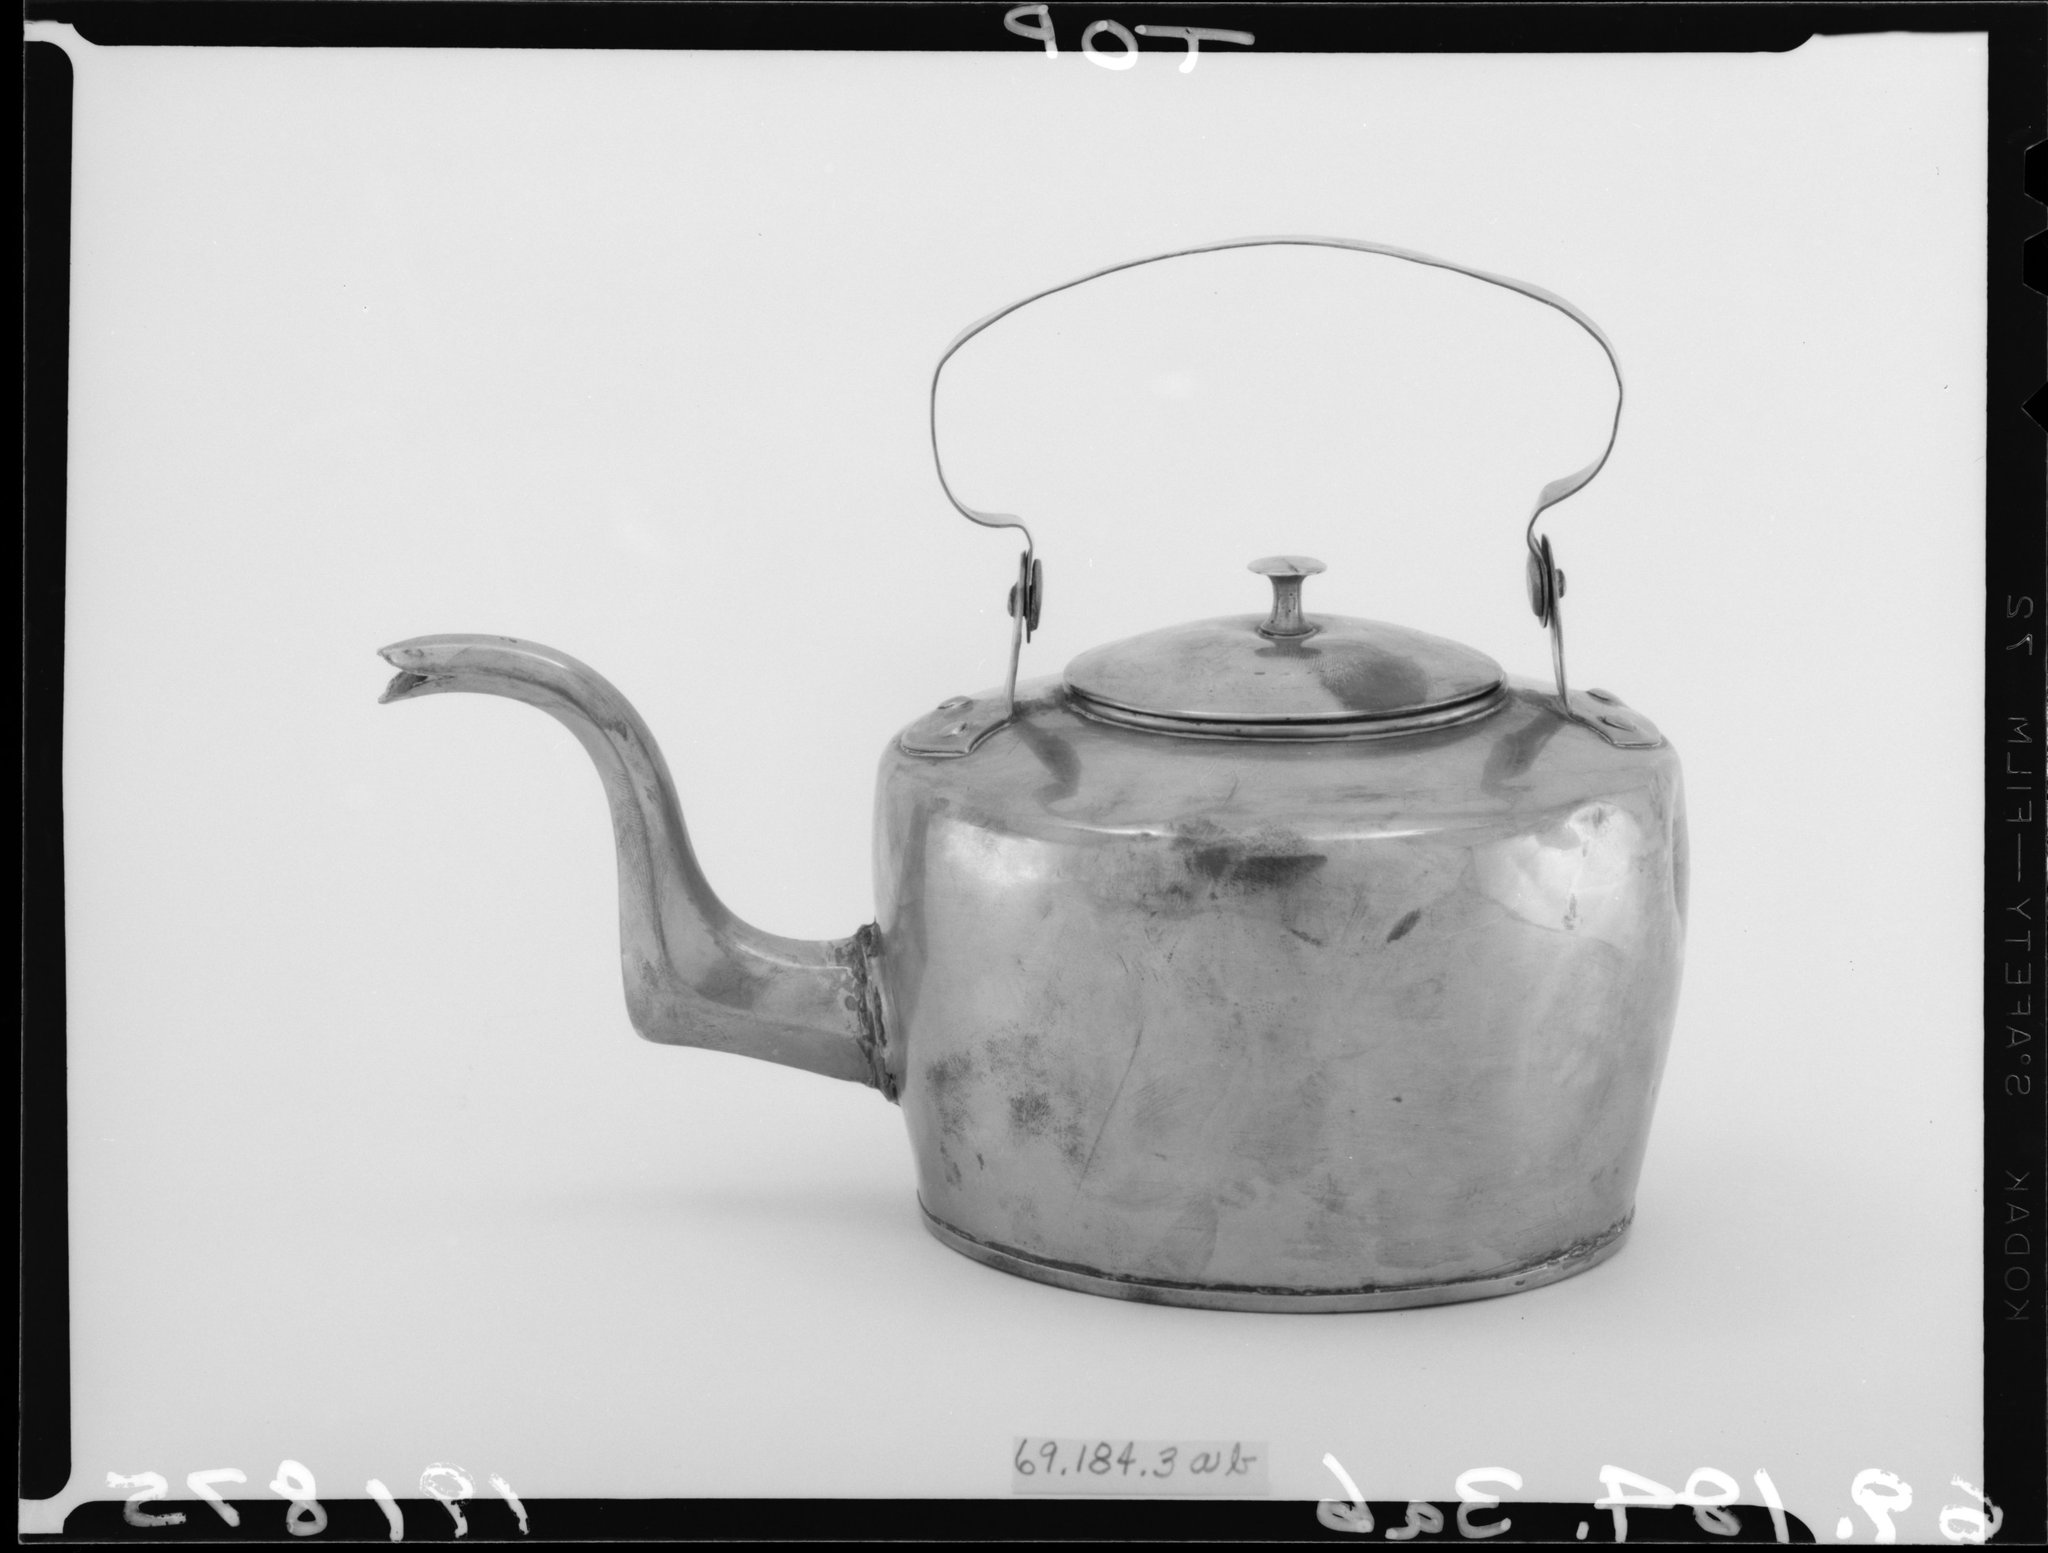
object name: teakettle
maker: j. dunn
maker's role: maker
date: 1800-1830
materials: copper